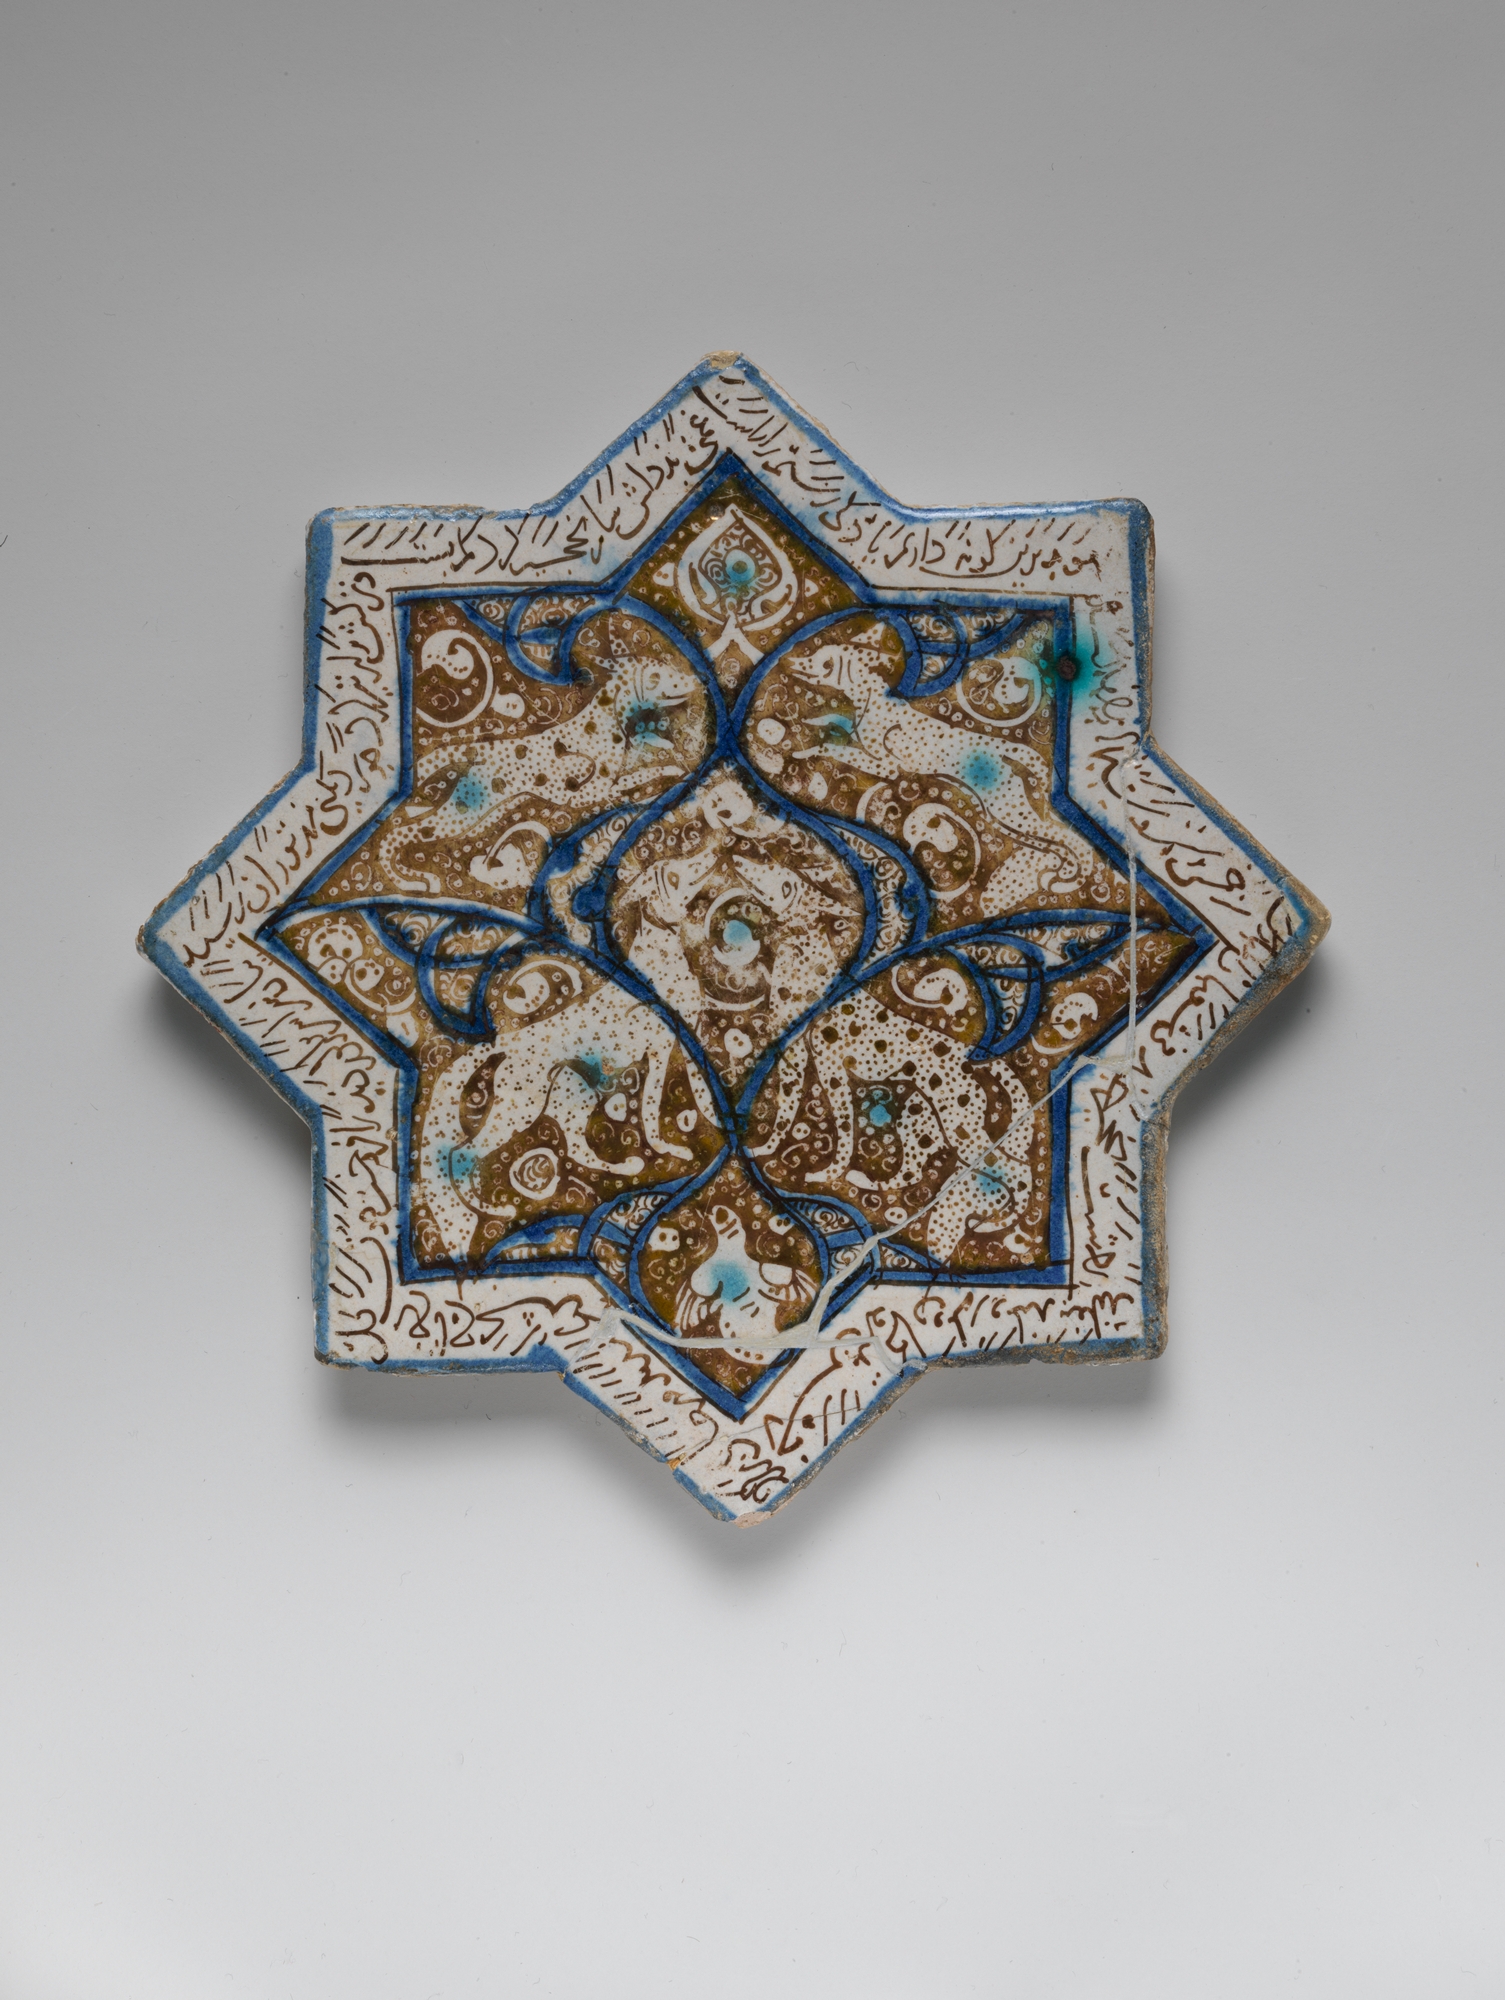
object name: tile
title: Eight-pointed Star Tile Depicting Animals and Inscription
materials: glaze, stonepaste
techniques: luster painting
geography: iran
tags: animals